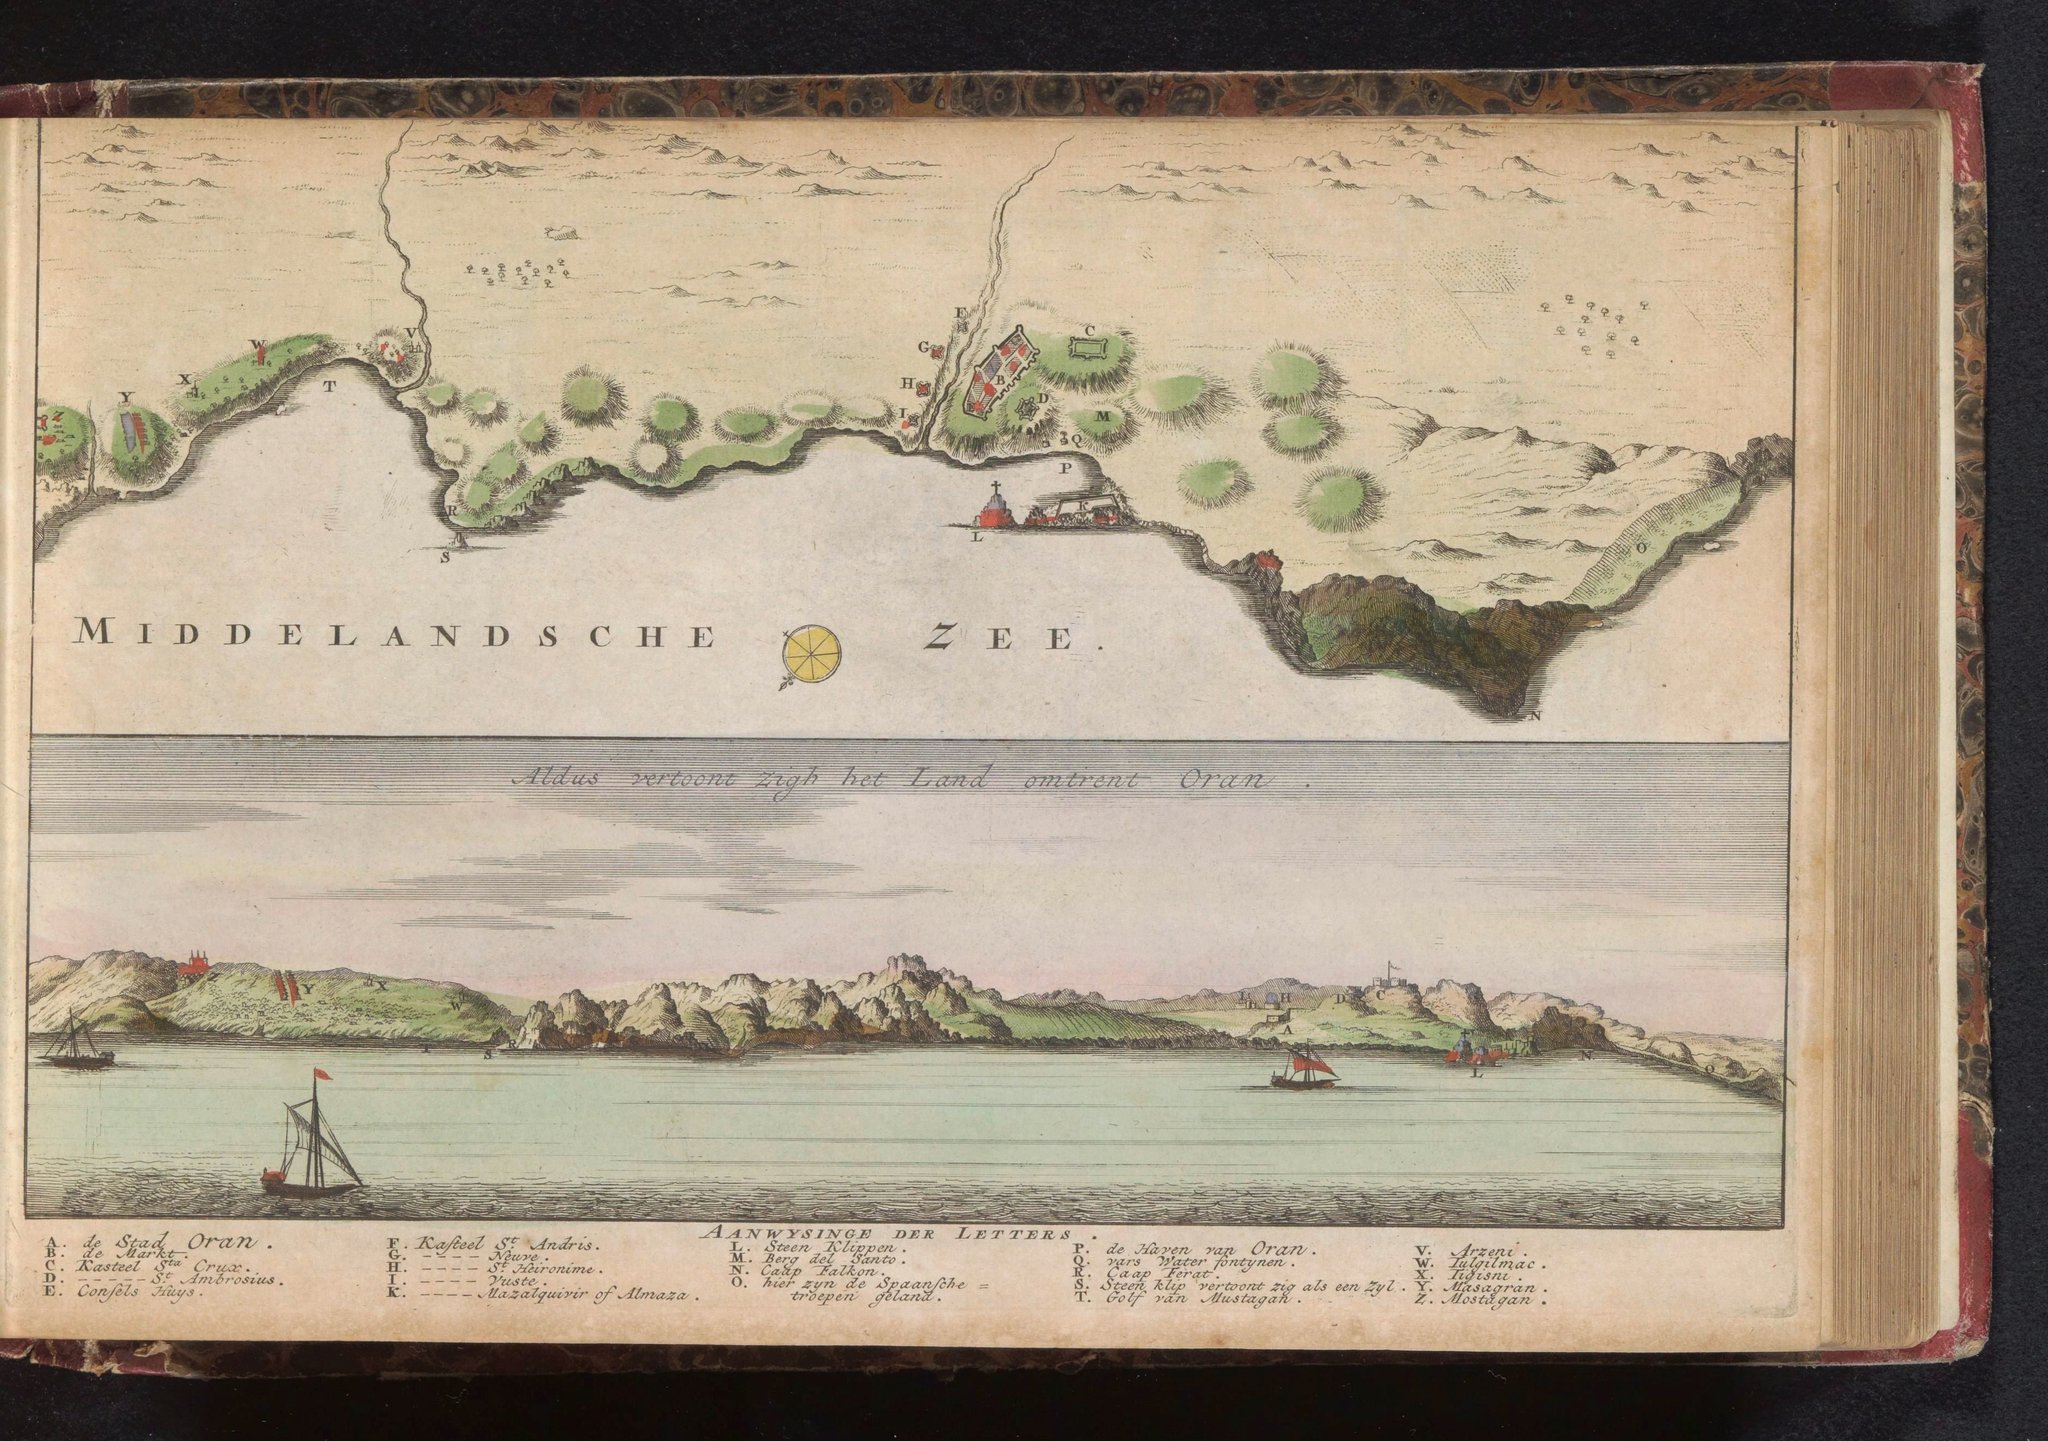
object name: print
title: Aldus vertoont zigh het Land omtrent Oran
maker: Anonymous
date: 1735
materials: paper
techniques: engraving, etching, hand coloring, lacquer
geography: northern netherlands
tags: maps of cities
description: Kaart van de Algerijnse kust met de plaats Oran, onderaan een gezicht op de stad. Onderdeel van een atlas met 223 kaarten van landen en steden en oorlogstaferelen in Europa in de periode ca. 1690-1735.